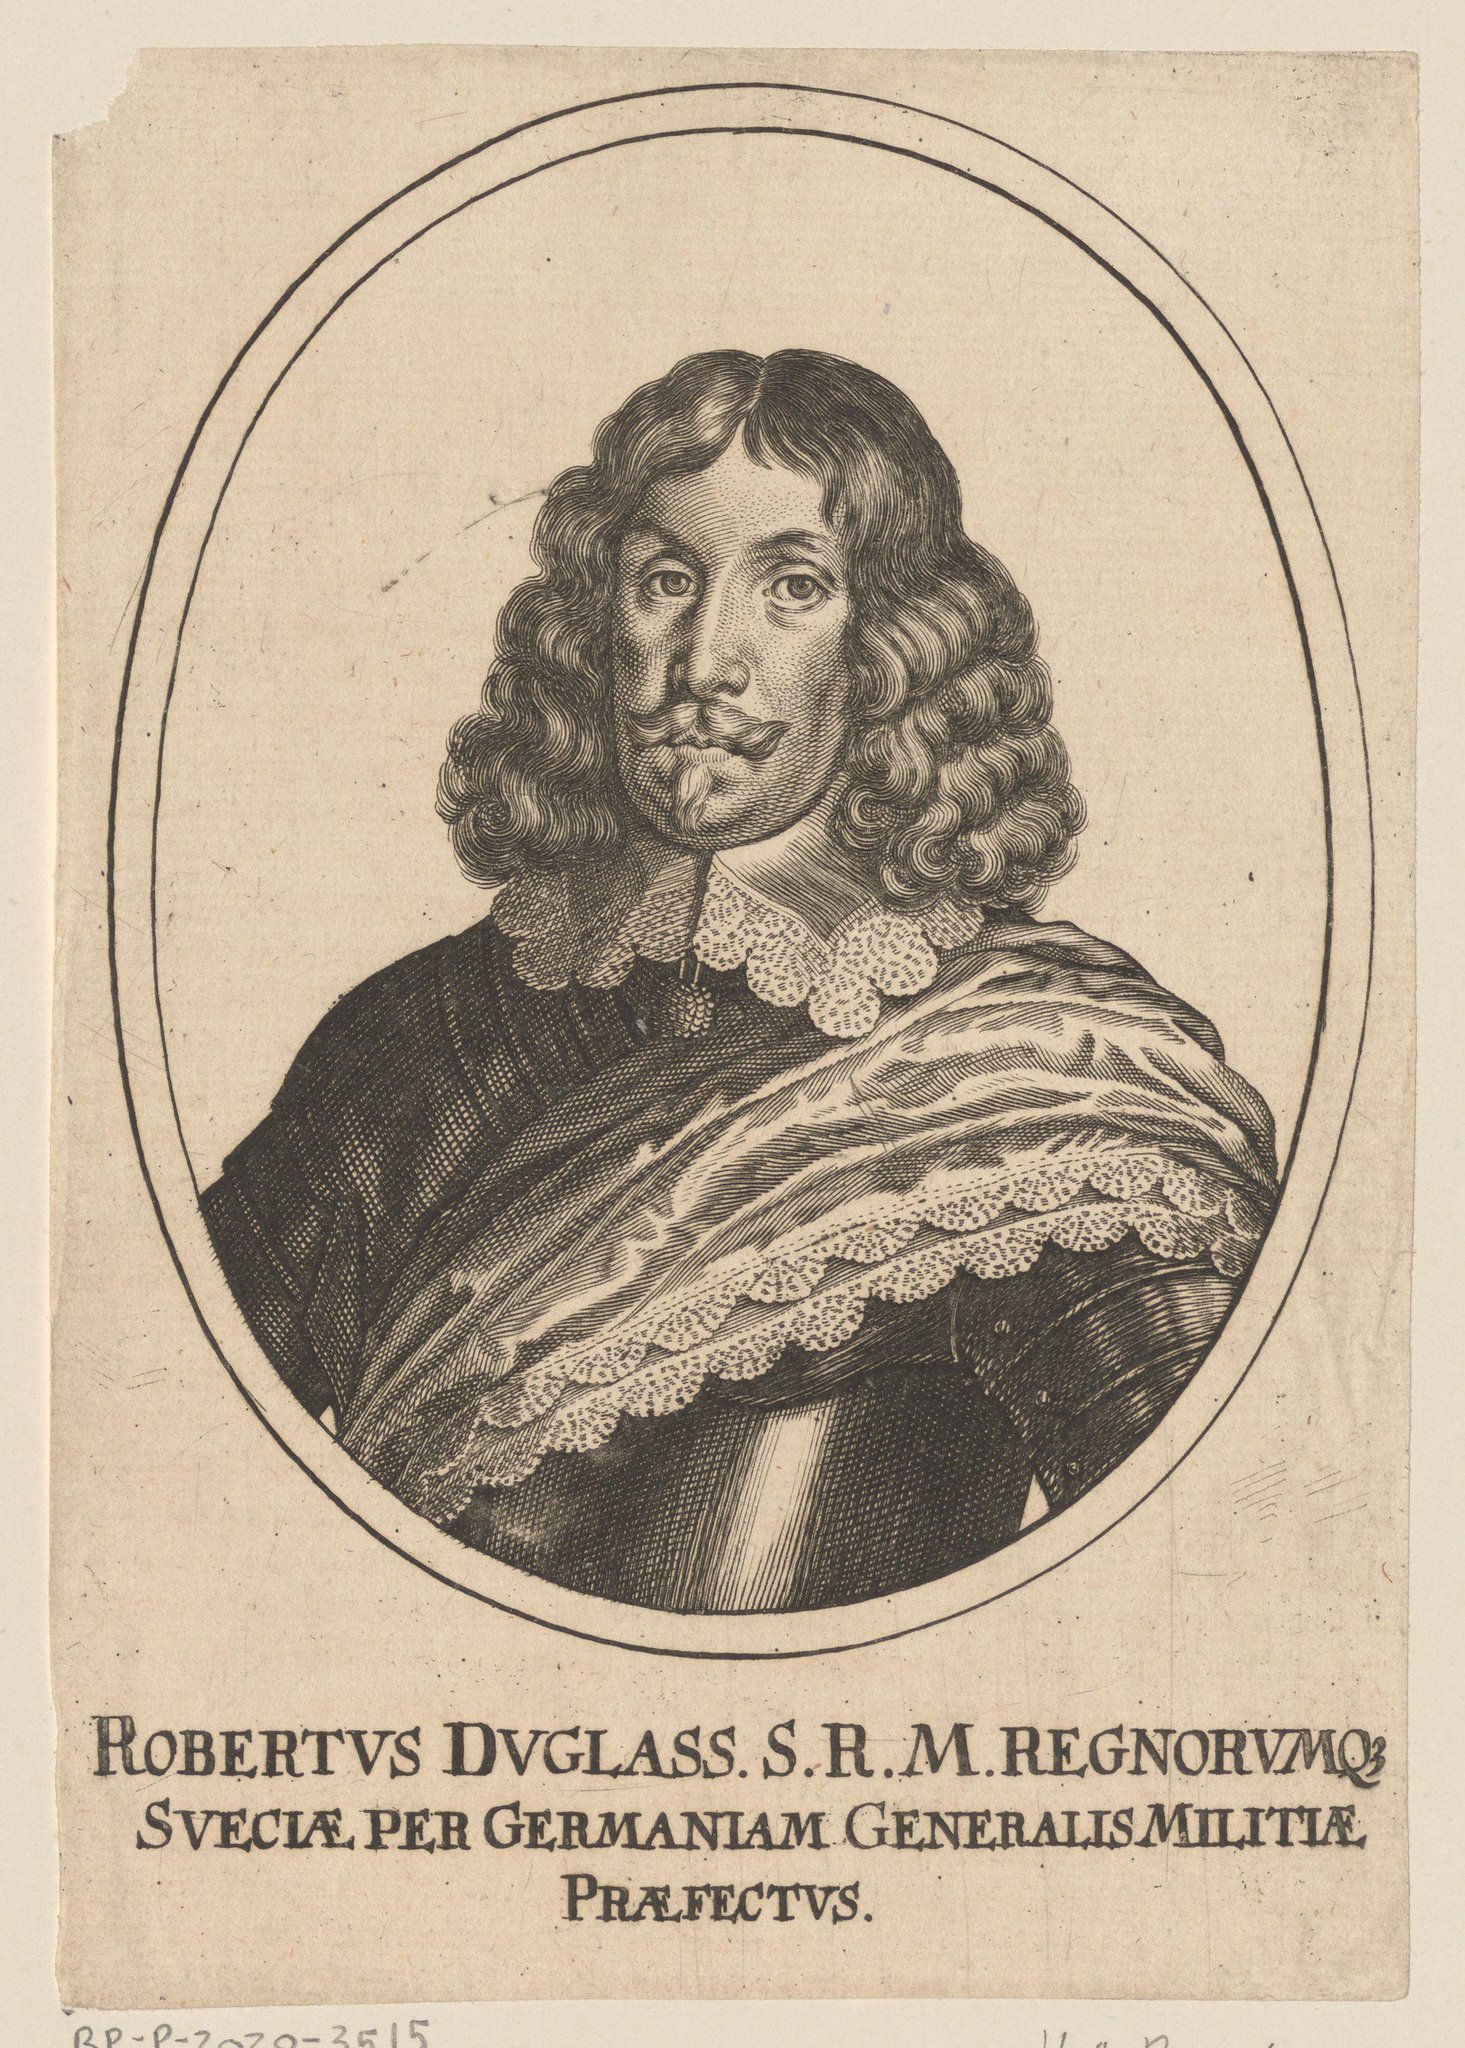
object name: print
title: Portret van Rupert Douglas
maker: peter aubry (iii)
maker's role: print maker, publisher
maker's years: 1610-1686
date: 1652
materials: paper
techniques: engraving, etching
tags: commander-in-chief, general, marshal, historical persons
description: Prent waarschijnlijk uit: Schleder, Johann Georg. Theatrum Europaeum. 21 dln. Frankfurt am Main: erven Matthäus Merian I, 1652, dl. 6.